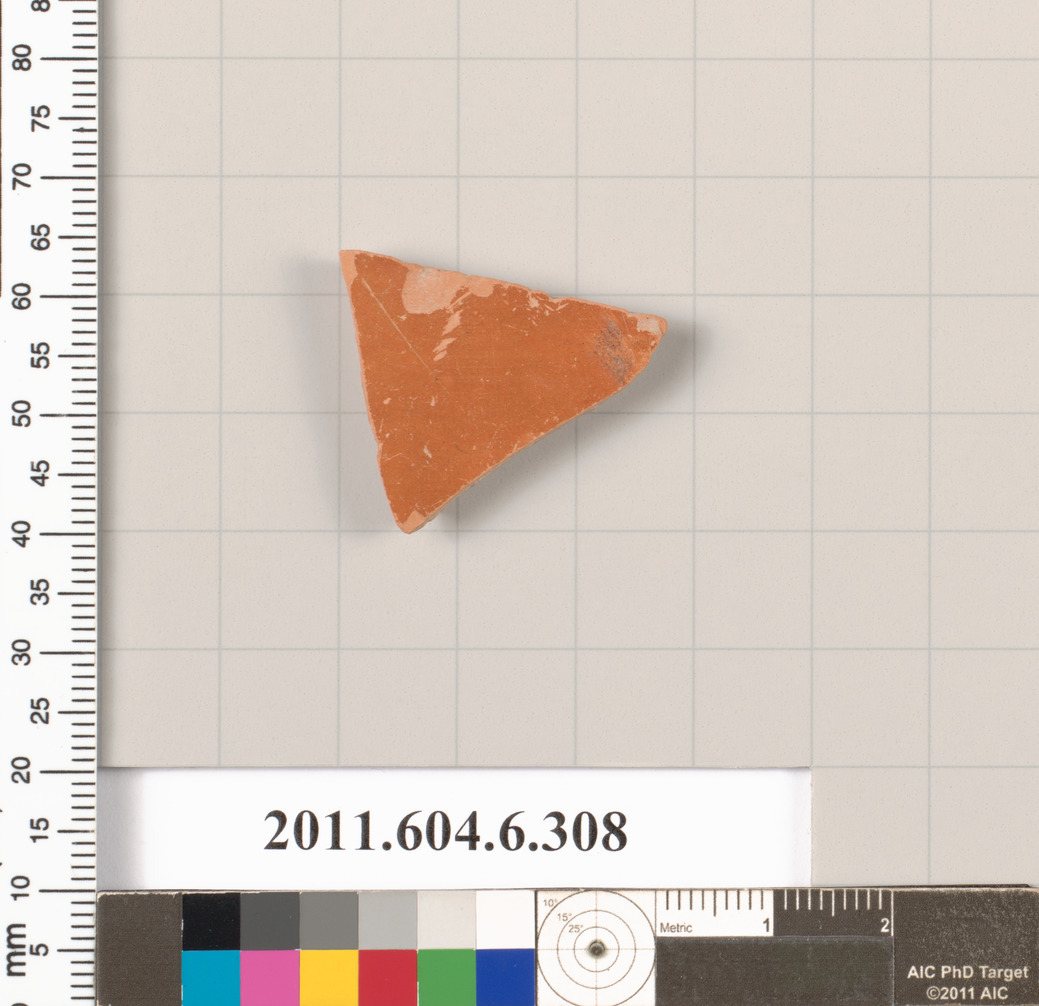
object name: undetermined open shape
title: Terracotta fragment of an open shape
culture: greek, attic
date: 600-401 BCE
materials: terracotta